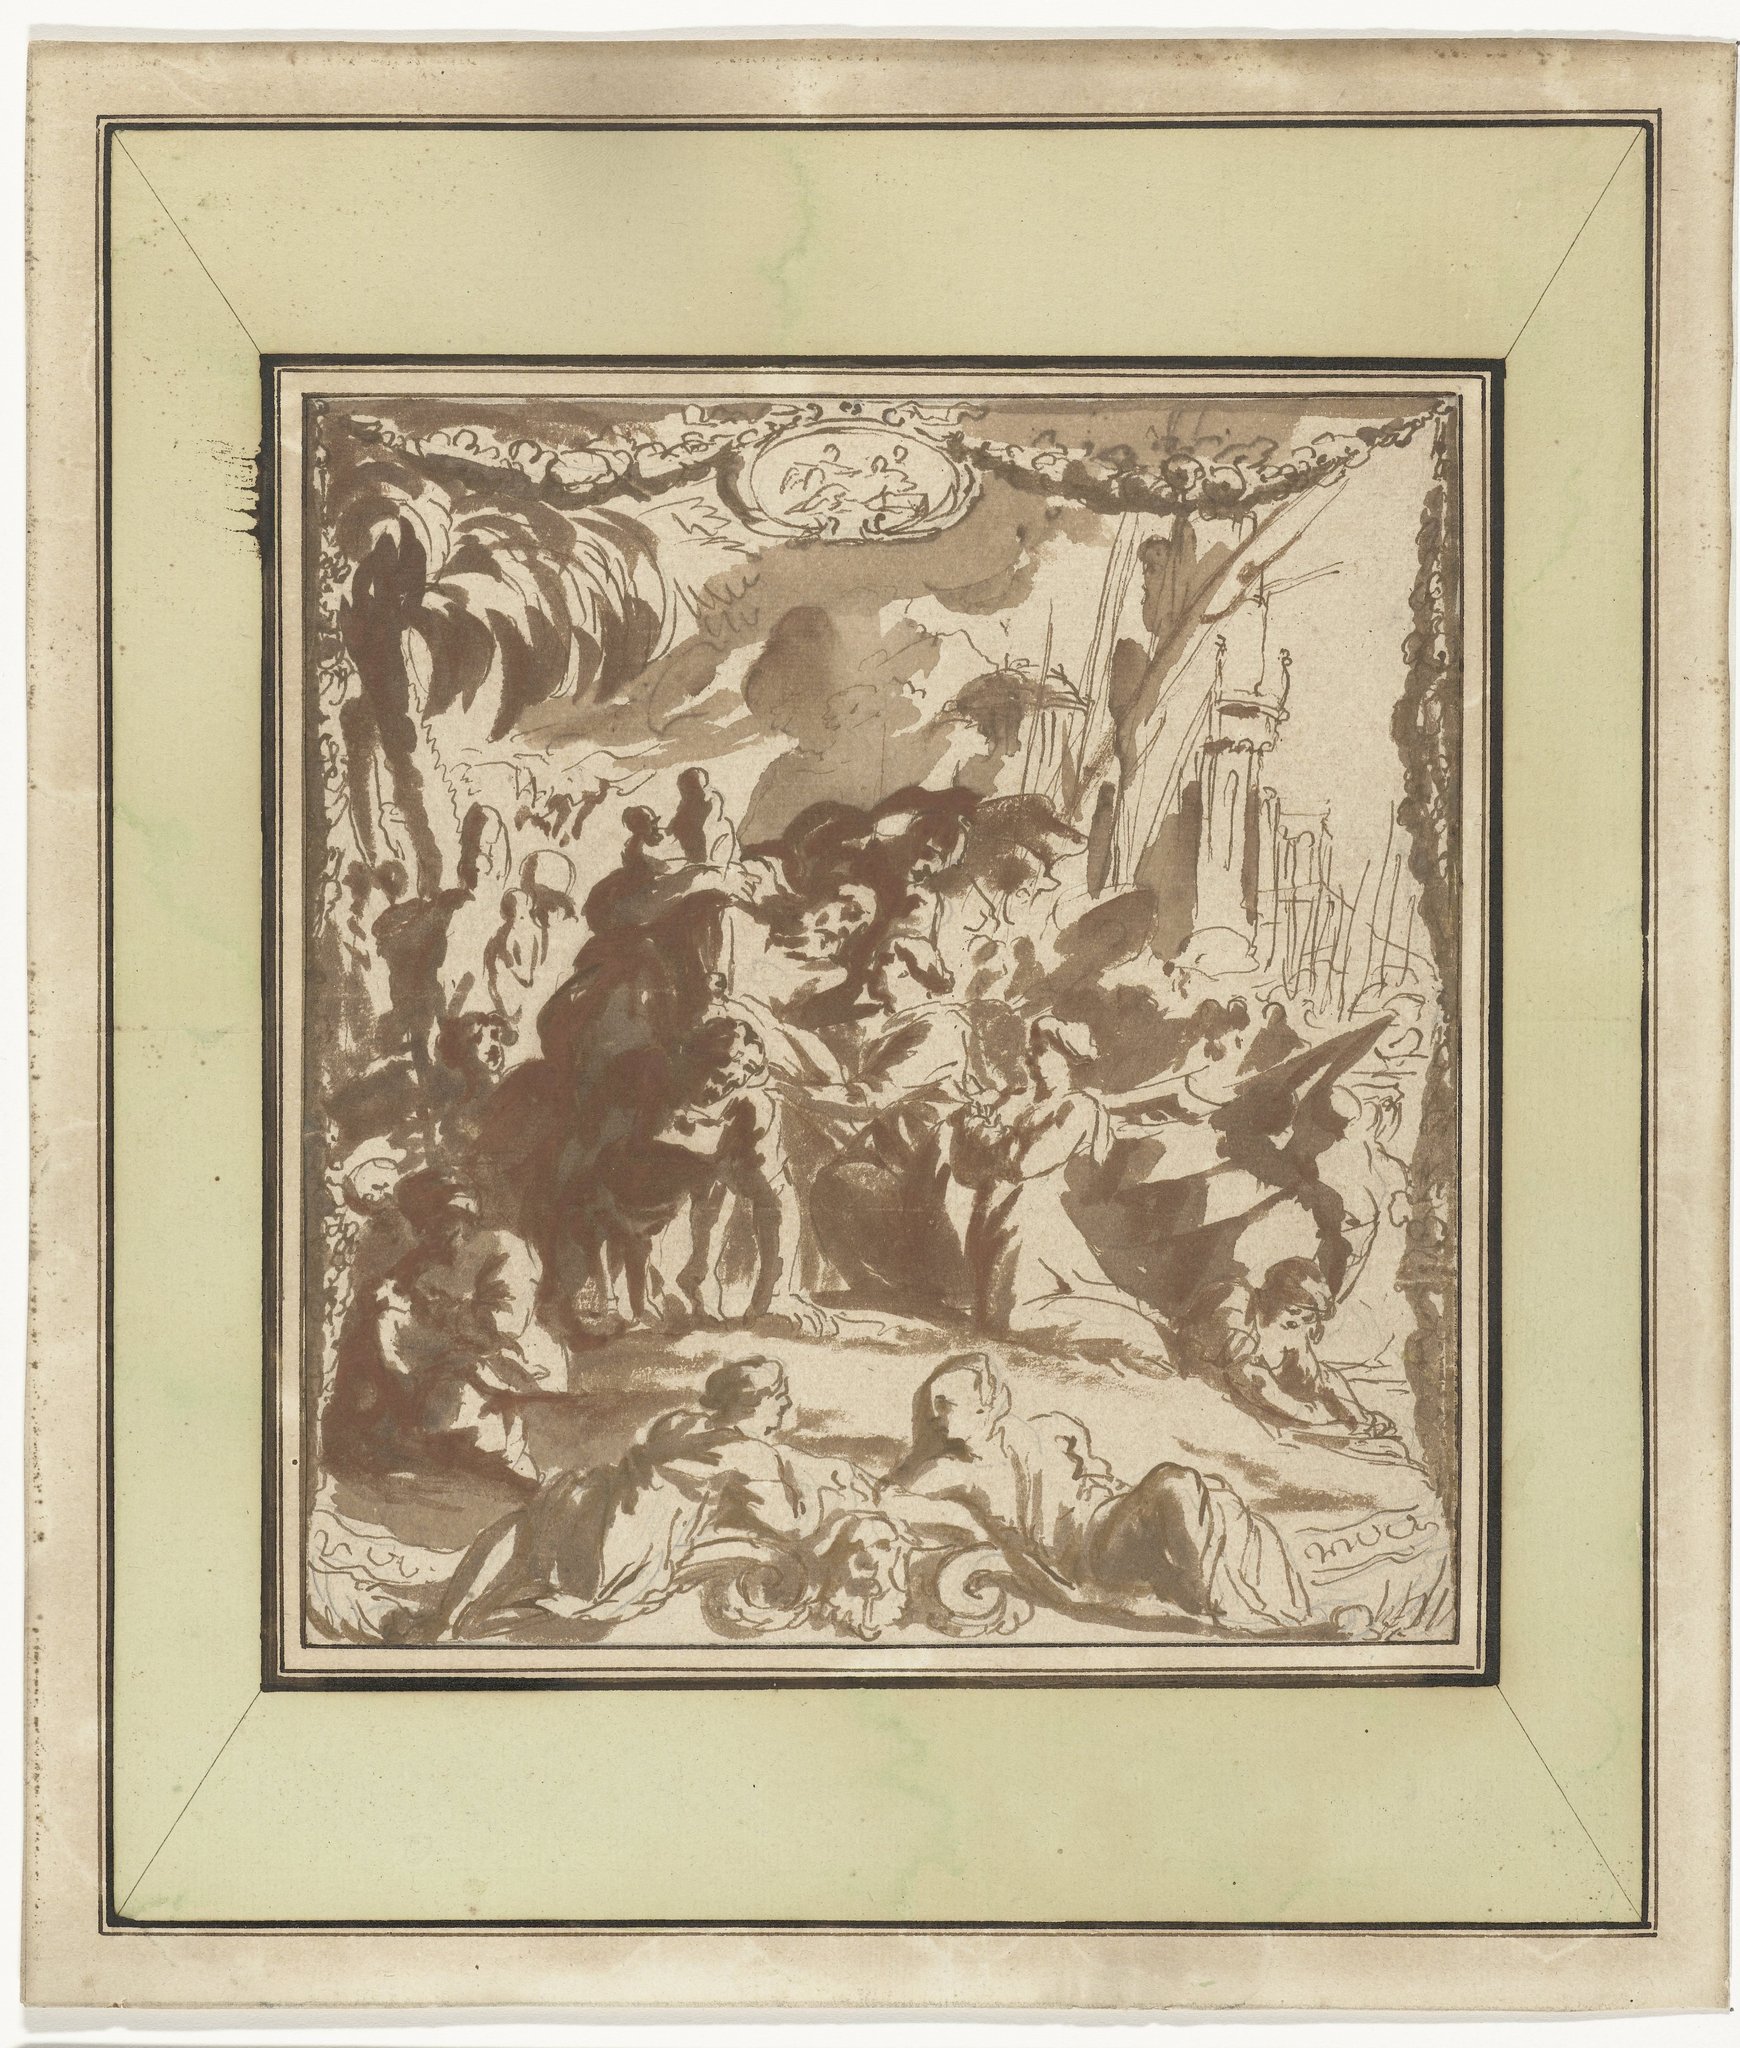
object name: design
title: Ontwerp voor een behangselschildering of wandtapijt met Anchises en Aeneas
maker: augustinus terwesten (i)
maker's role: draughtsman, painter, print maker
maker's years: 1649-1711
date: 1659-1711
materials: ink, paper, pencil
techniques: brush, pen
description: Anchises wordt van Aeneas' schouders getild na het brandende Troje verlaten te hebben. Met een decoratieve omlijsting van figuren en festoenen.